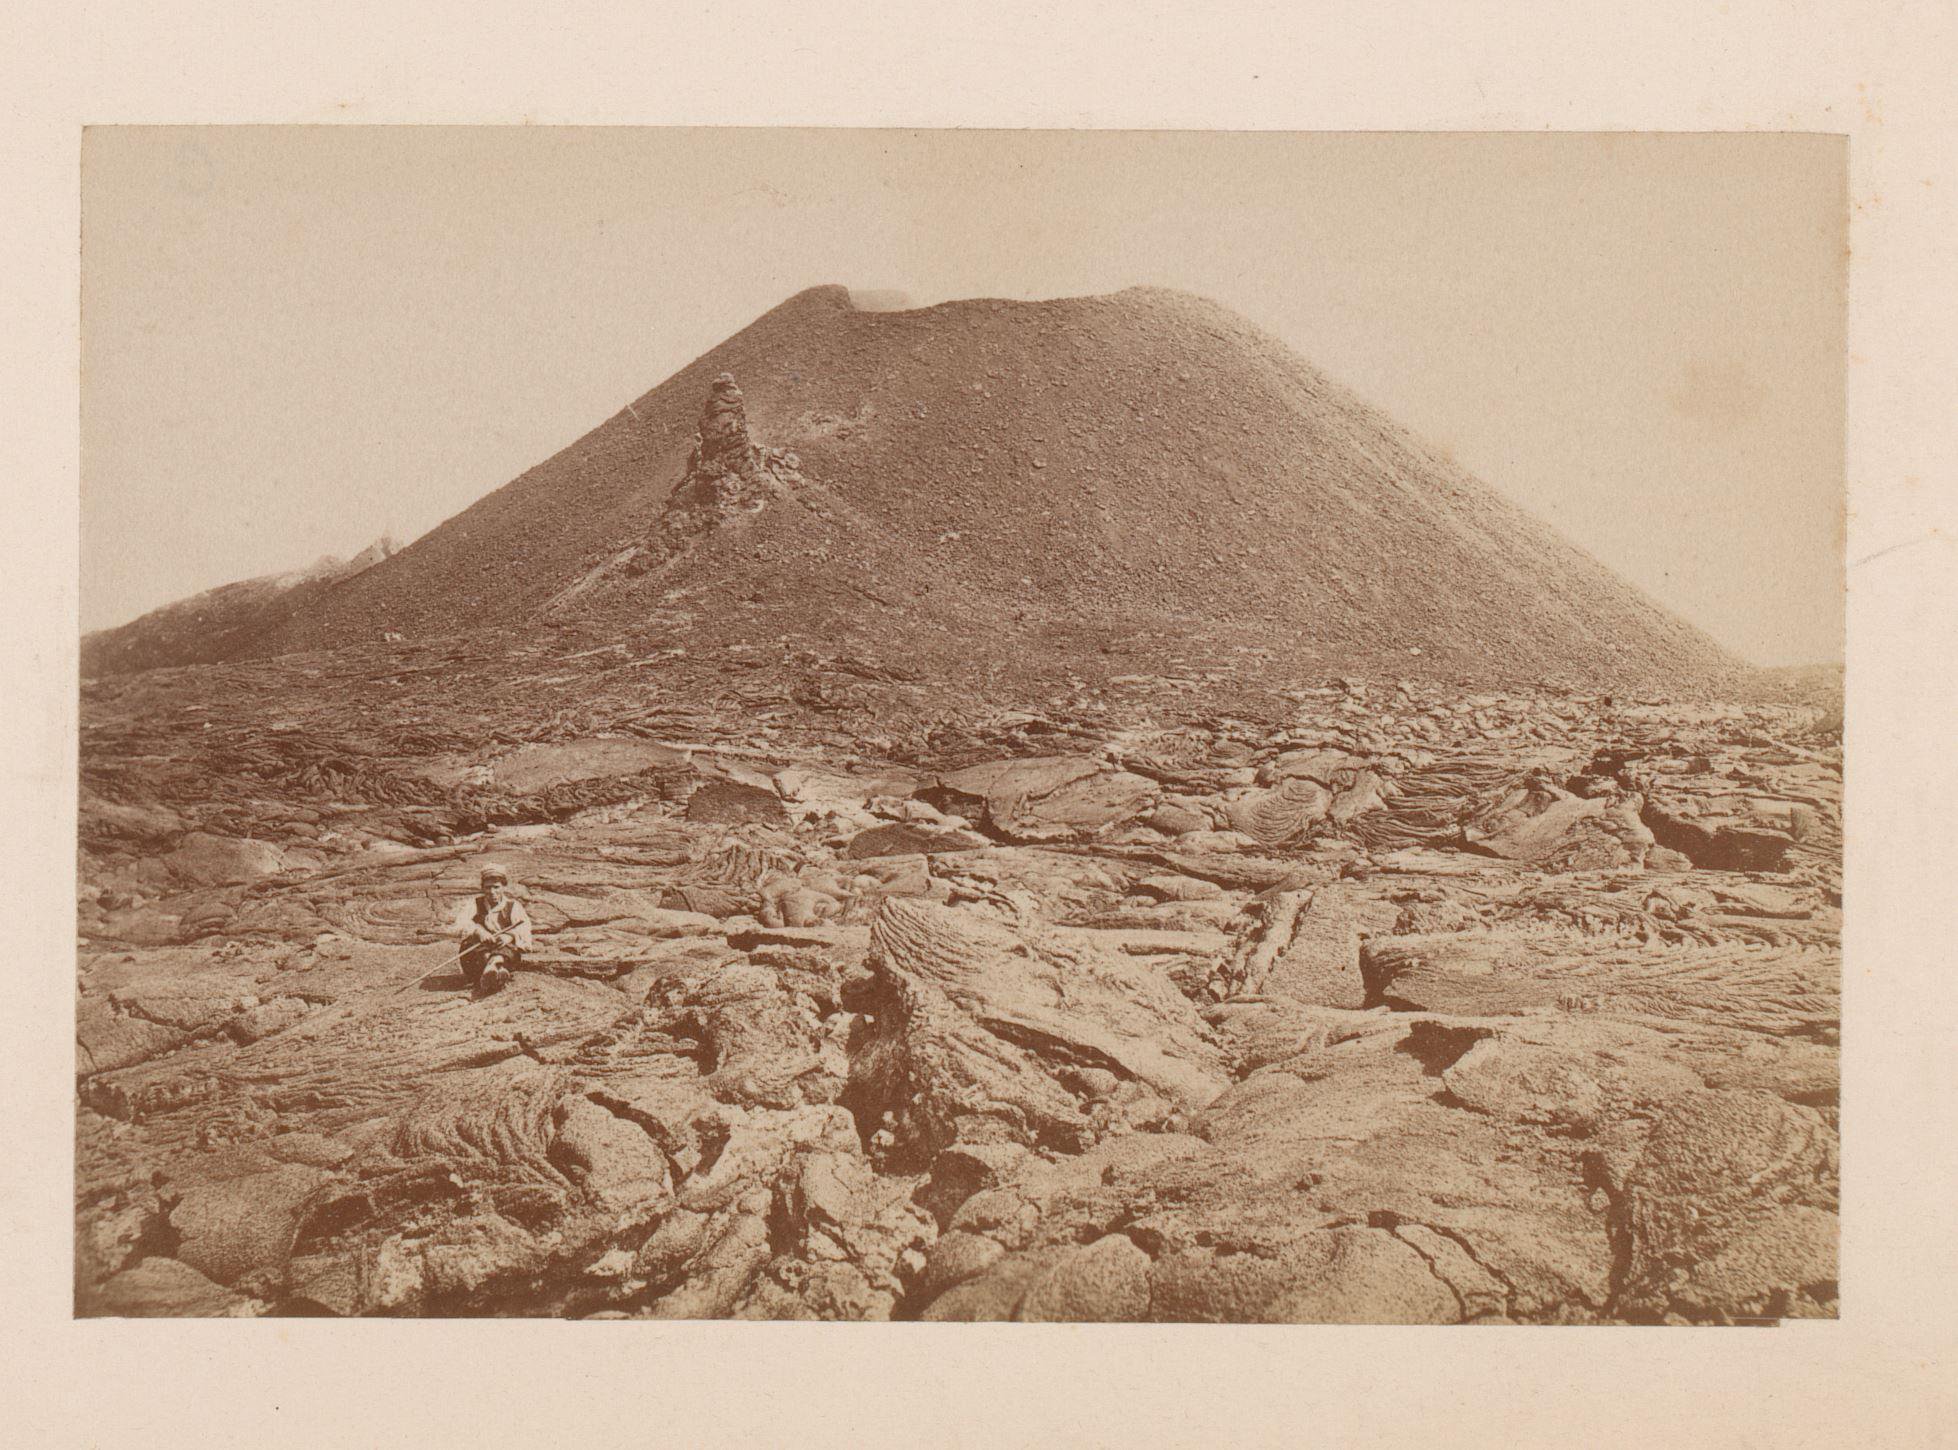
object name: photograph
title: Contorni di Napoli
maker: giacomo brogi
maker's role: fotograaf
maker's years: 1822-1881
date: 1880-1881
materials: cardboard, paper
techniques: albumen print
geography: naples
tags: volcano, mount vesuvius, naples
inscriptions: inscription: ‘Napoli’, number: ‘5236.’